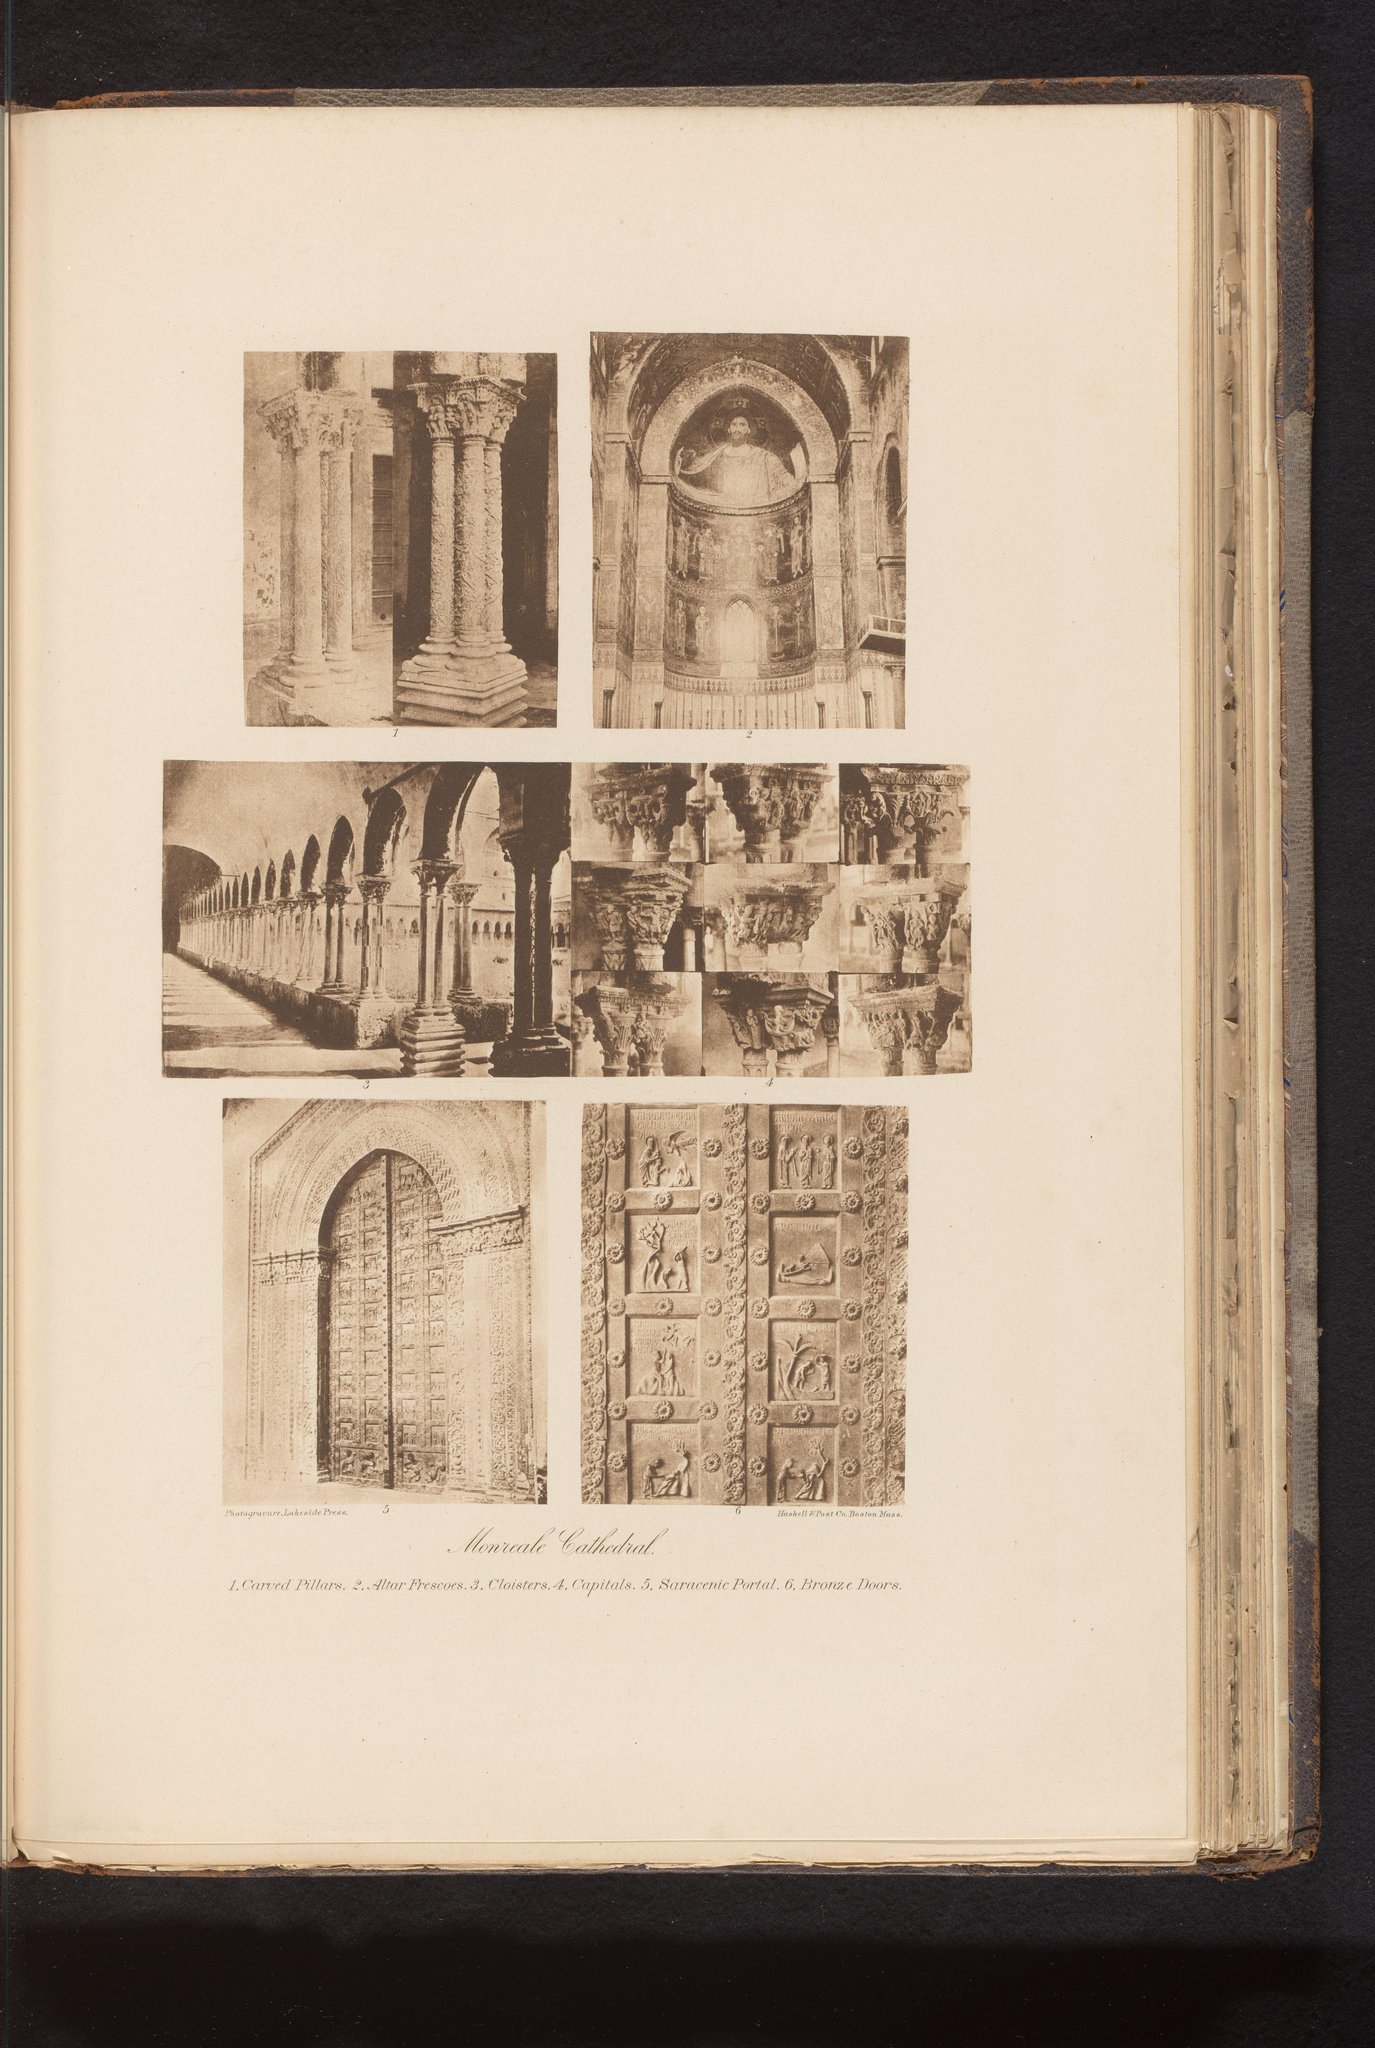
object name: page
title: Zes details van de kathedraal van Monreale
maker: Anonymous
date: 1881-1886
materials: paper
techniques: photograph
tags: parts of church interior (entrance), cloisters ~ monastery, sculpture (+ relief ~ sculpture)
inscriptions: inscription: ‘1, Carved Pillars. 2, Altar Frescoes. 3, Cloisters. 4, Capitals. 5, Saracenic Portal. 6, Bronze Doors.’